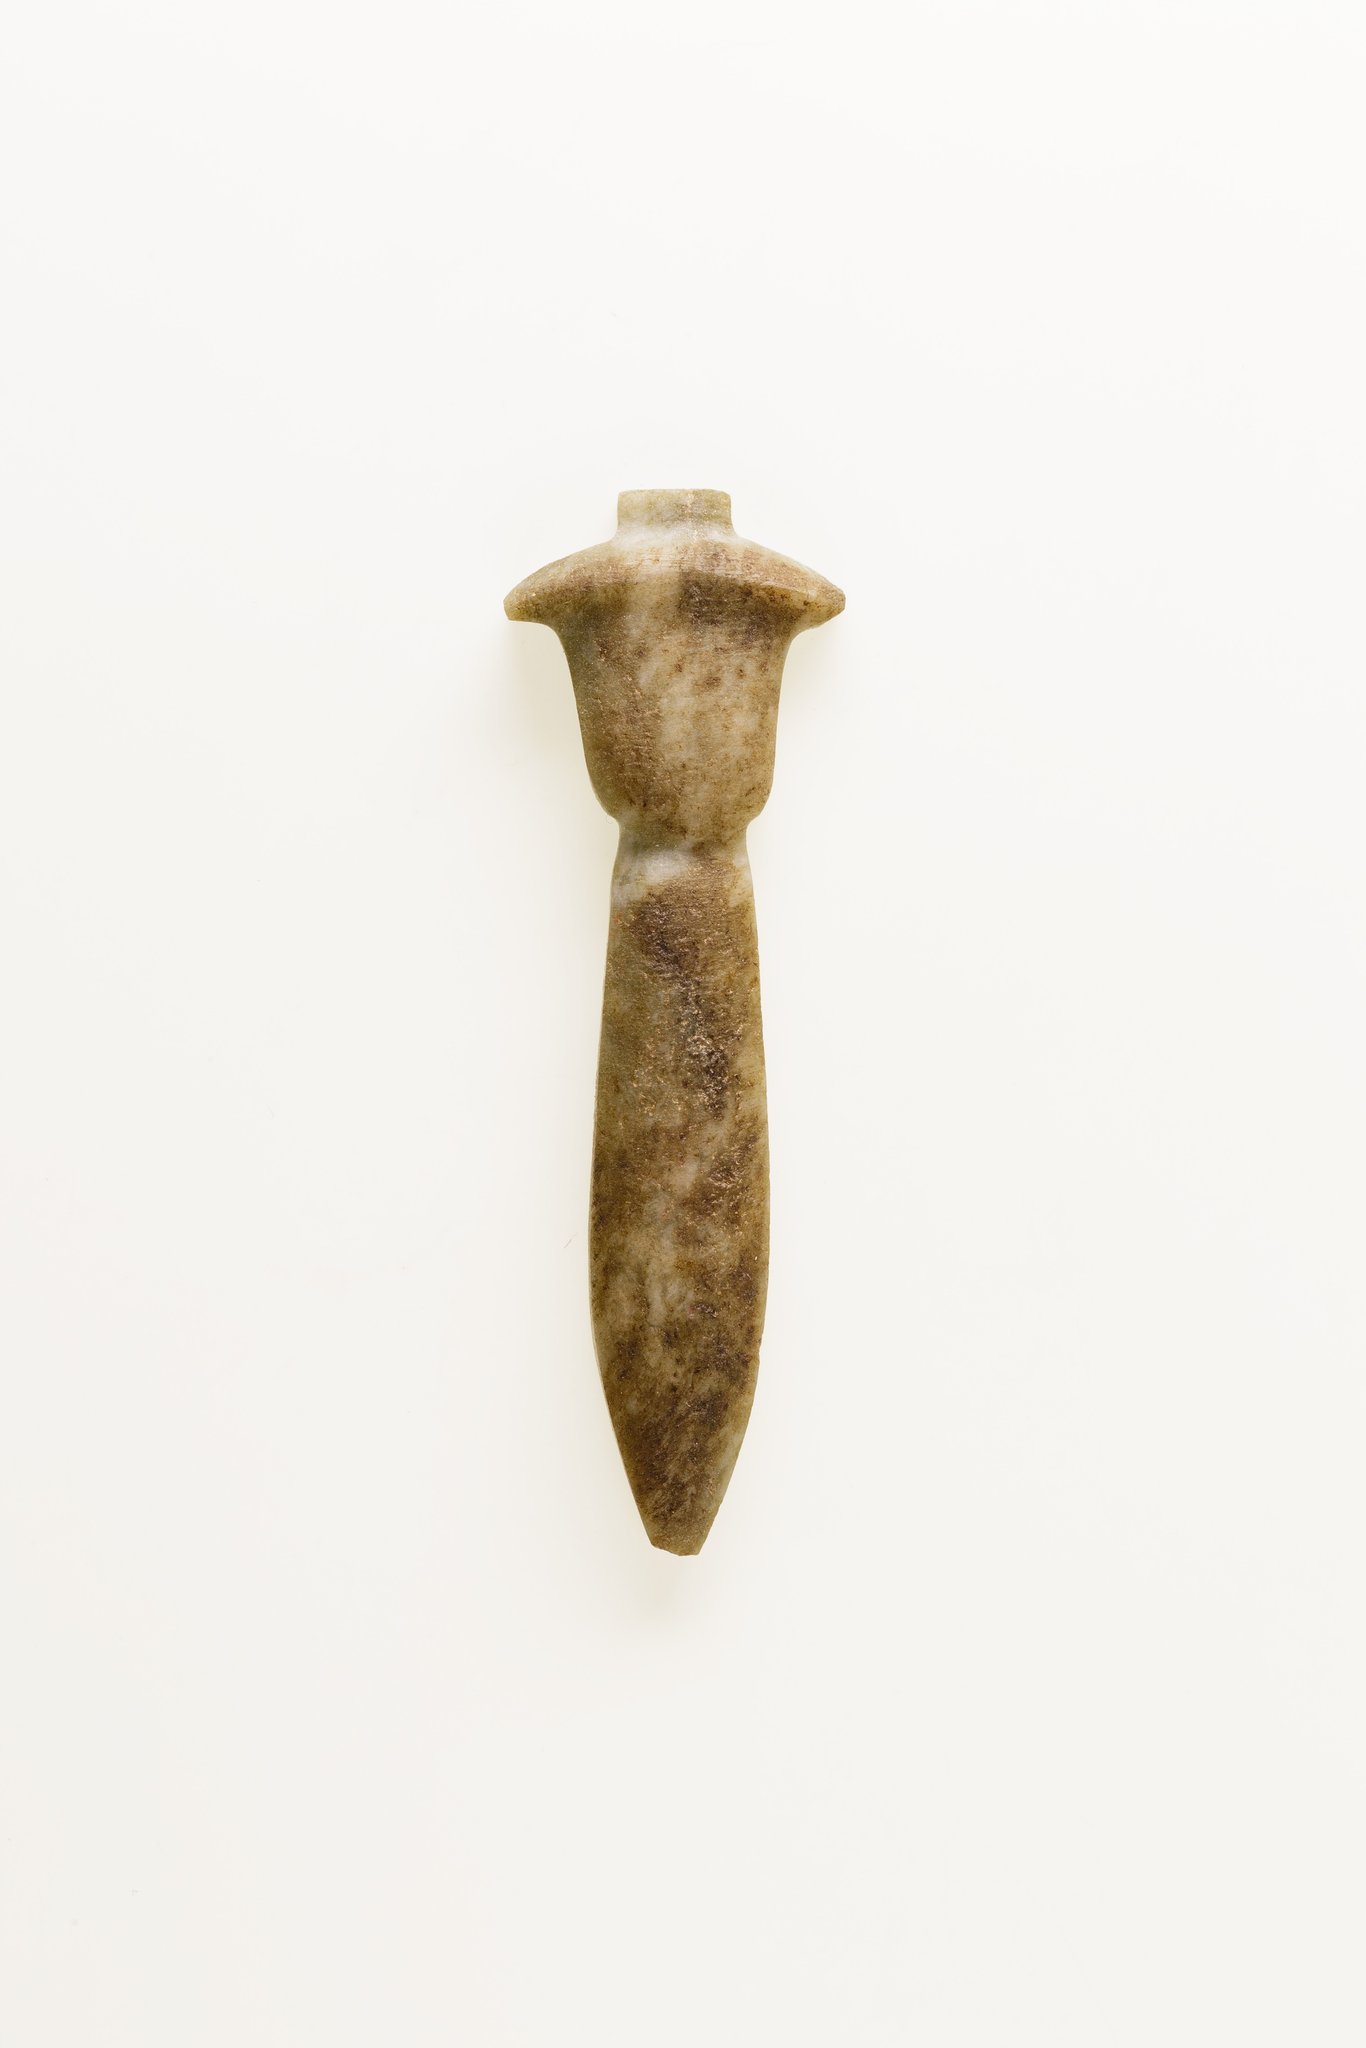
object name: inlay, hieroglyph, papyrus column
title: Papyrus column (wadj) inlay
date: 522-343 BCE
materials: stone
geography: egypt